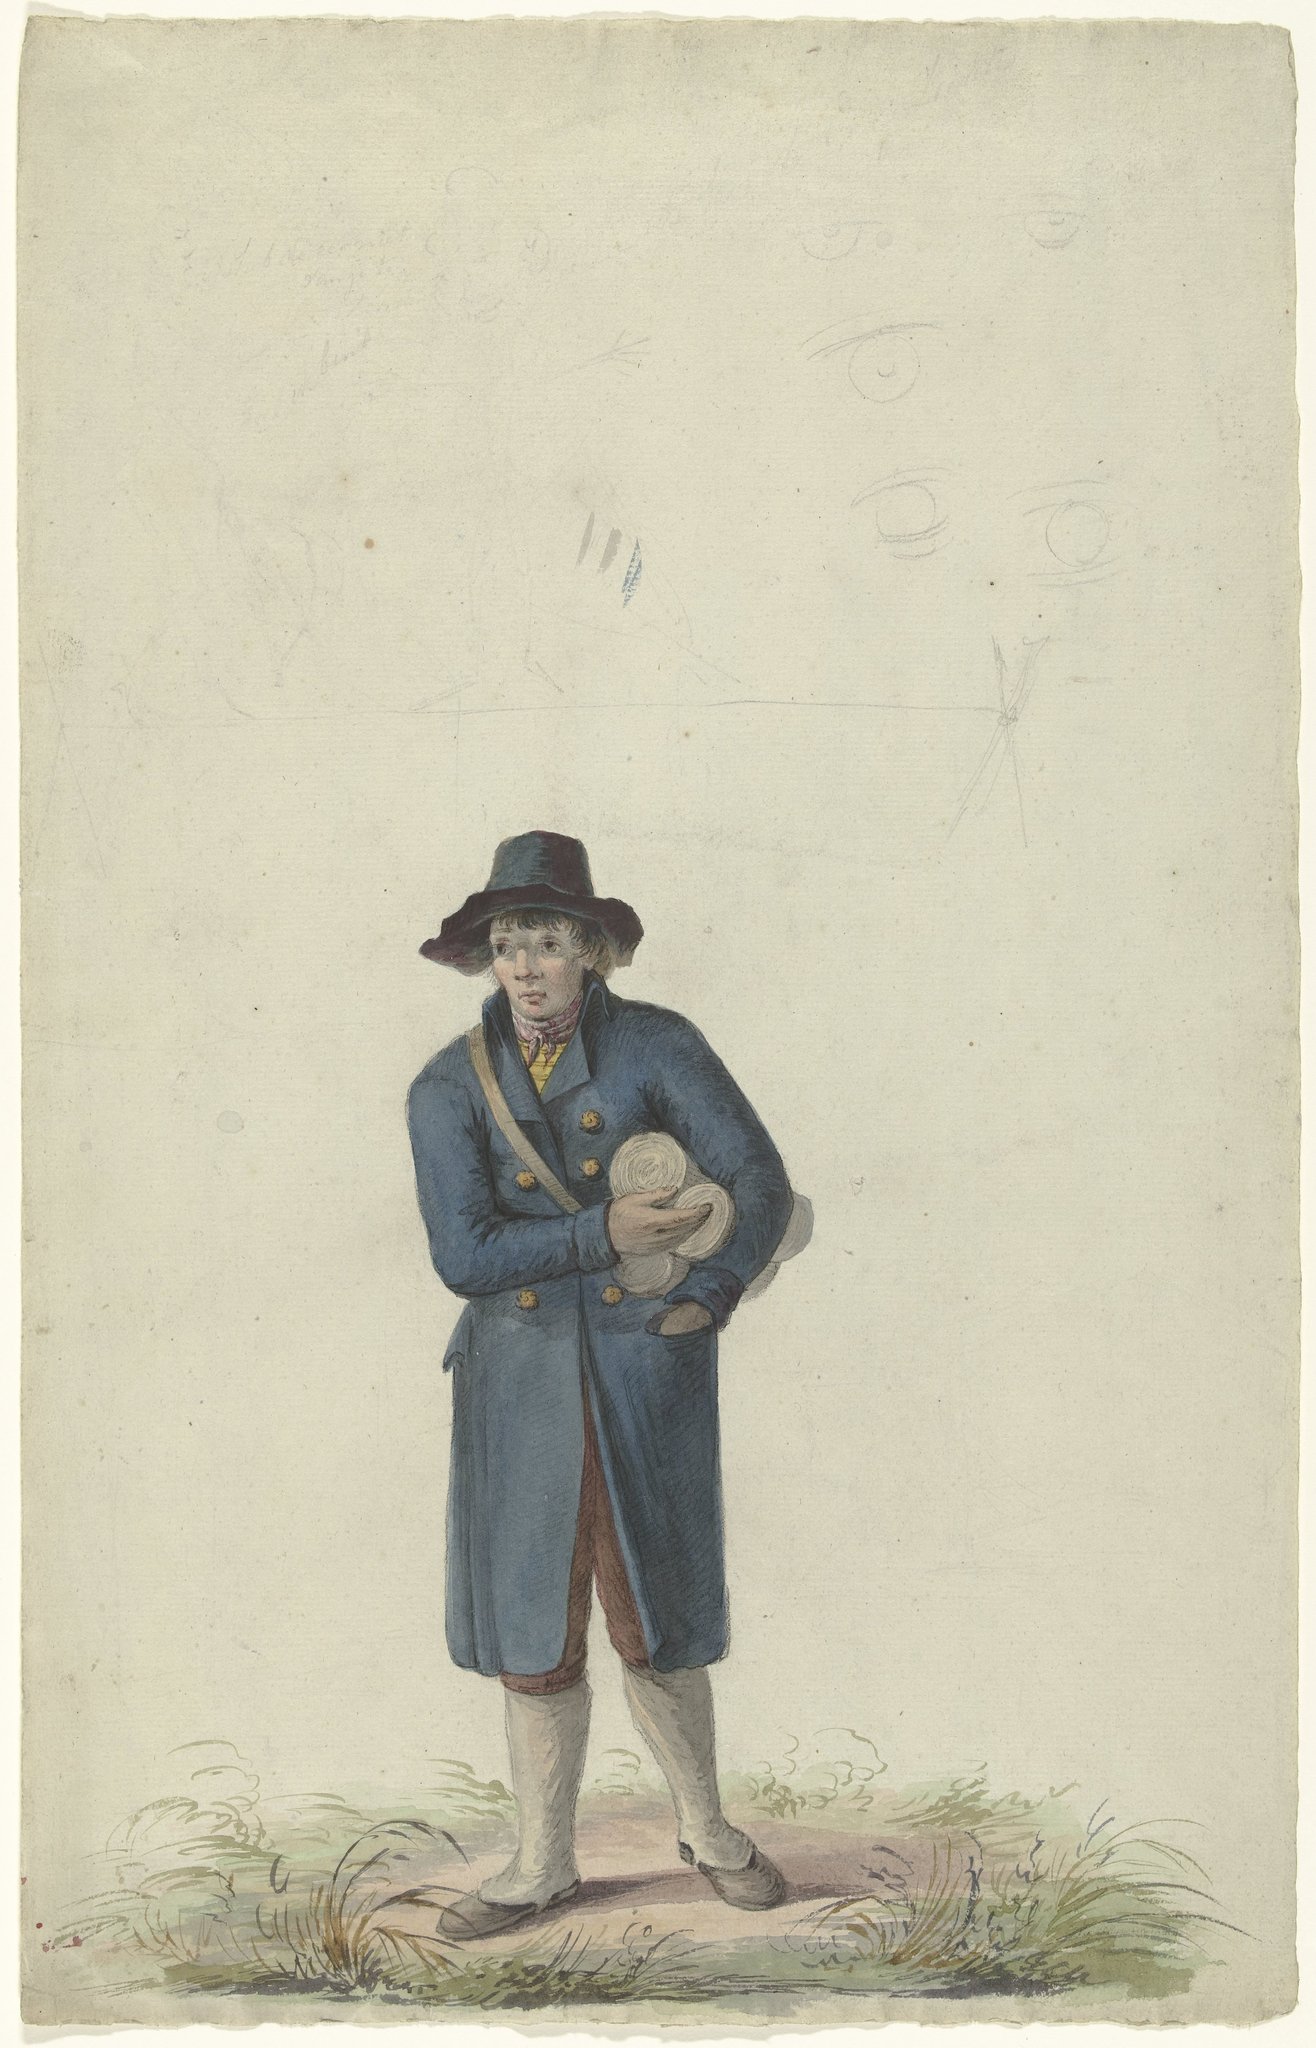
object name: watercolor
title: Staande man met drie rollen onder de arm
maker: Anonymous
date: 1700-1800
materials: chalk, paper, watercolor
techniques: brush